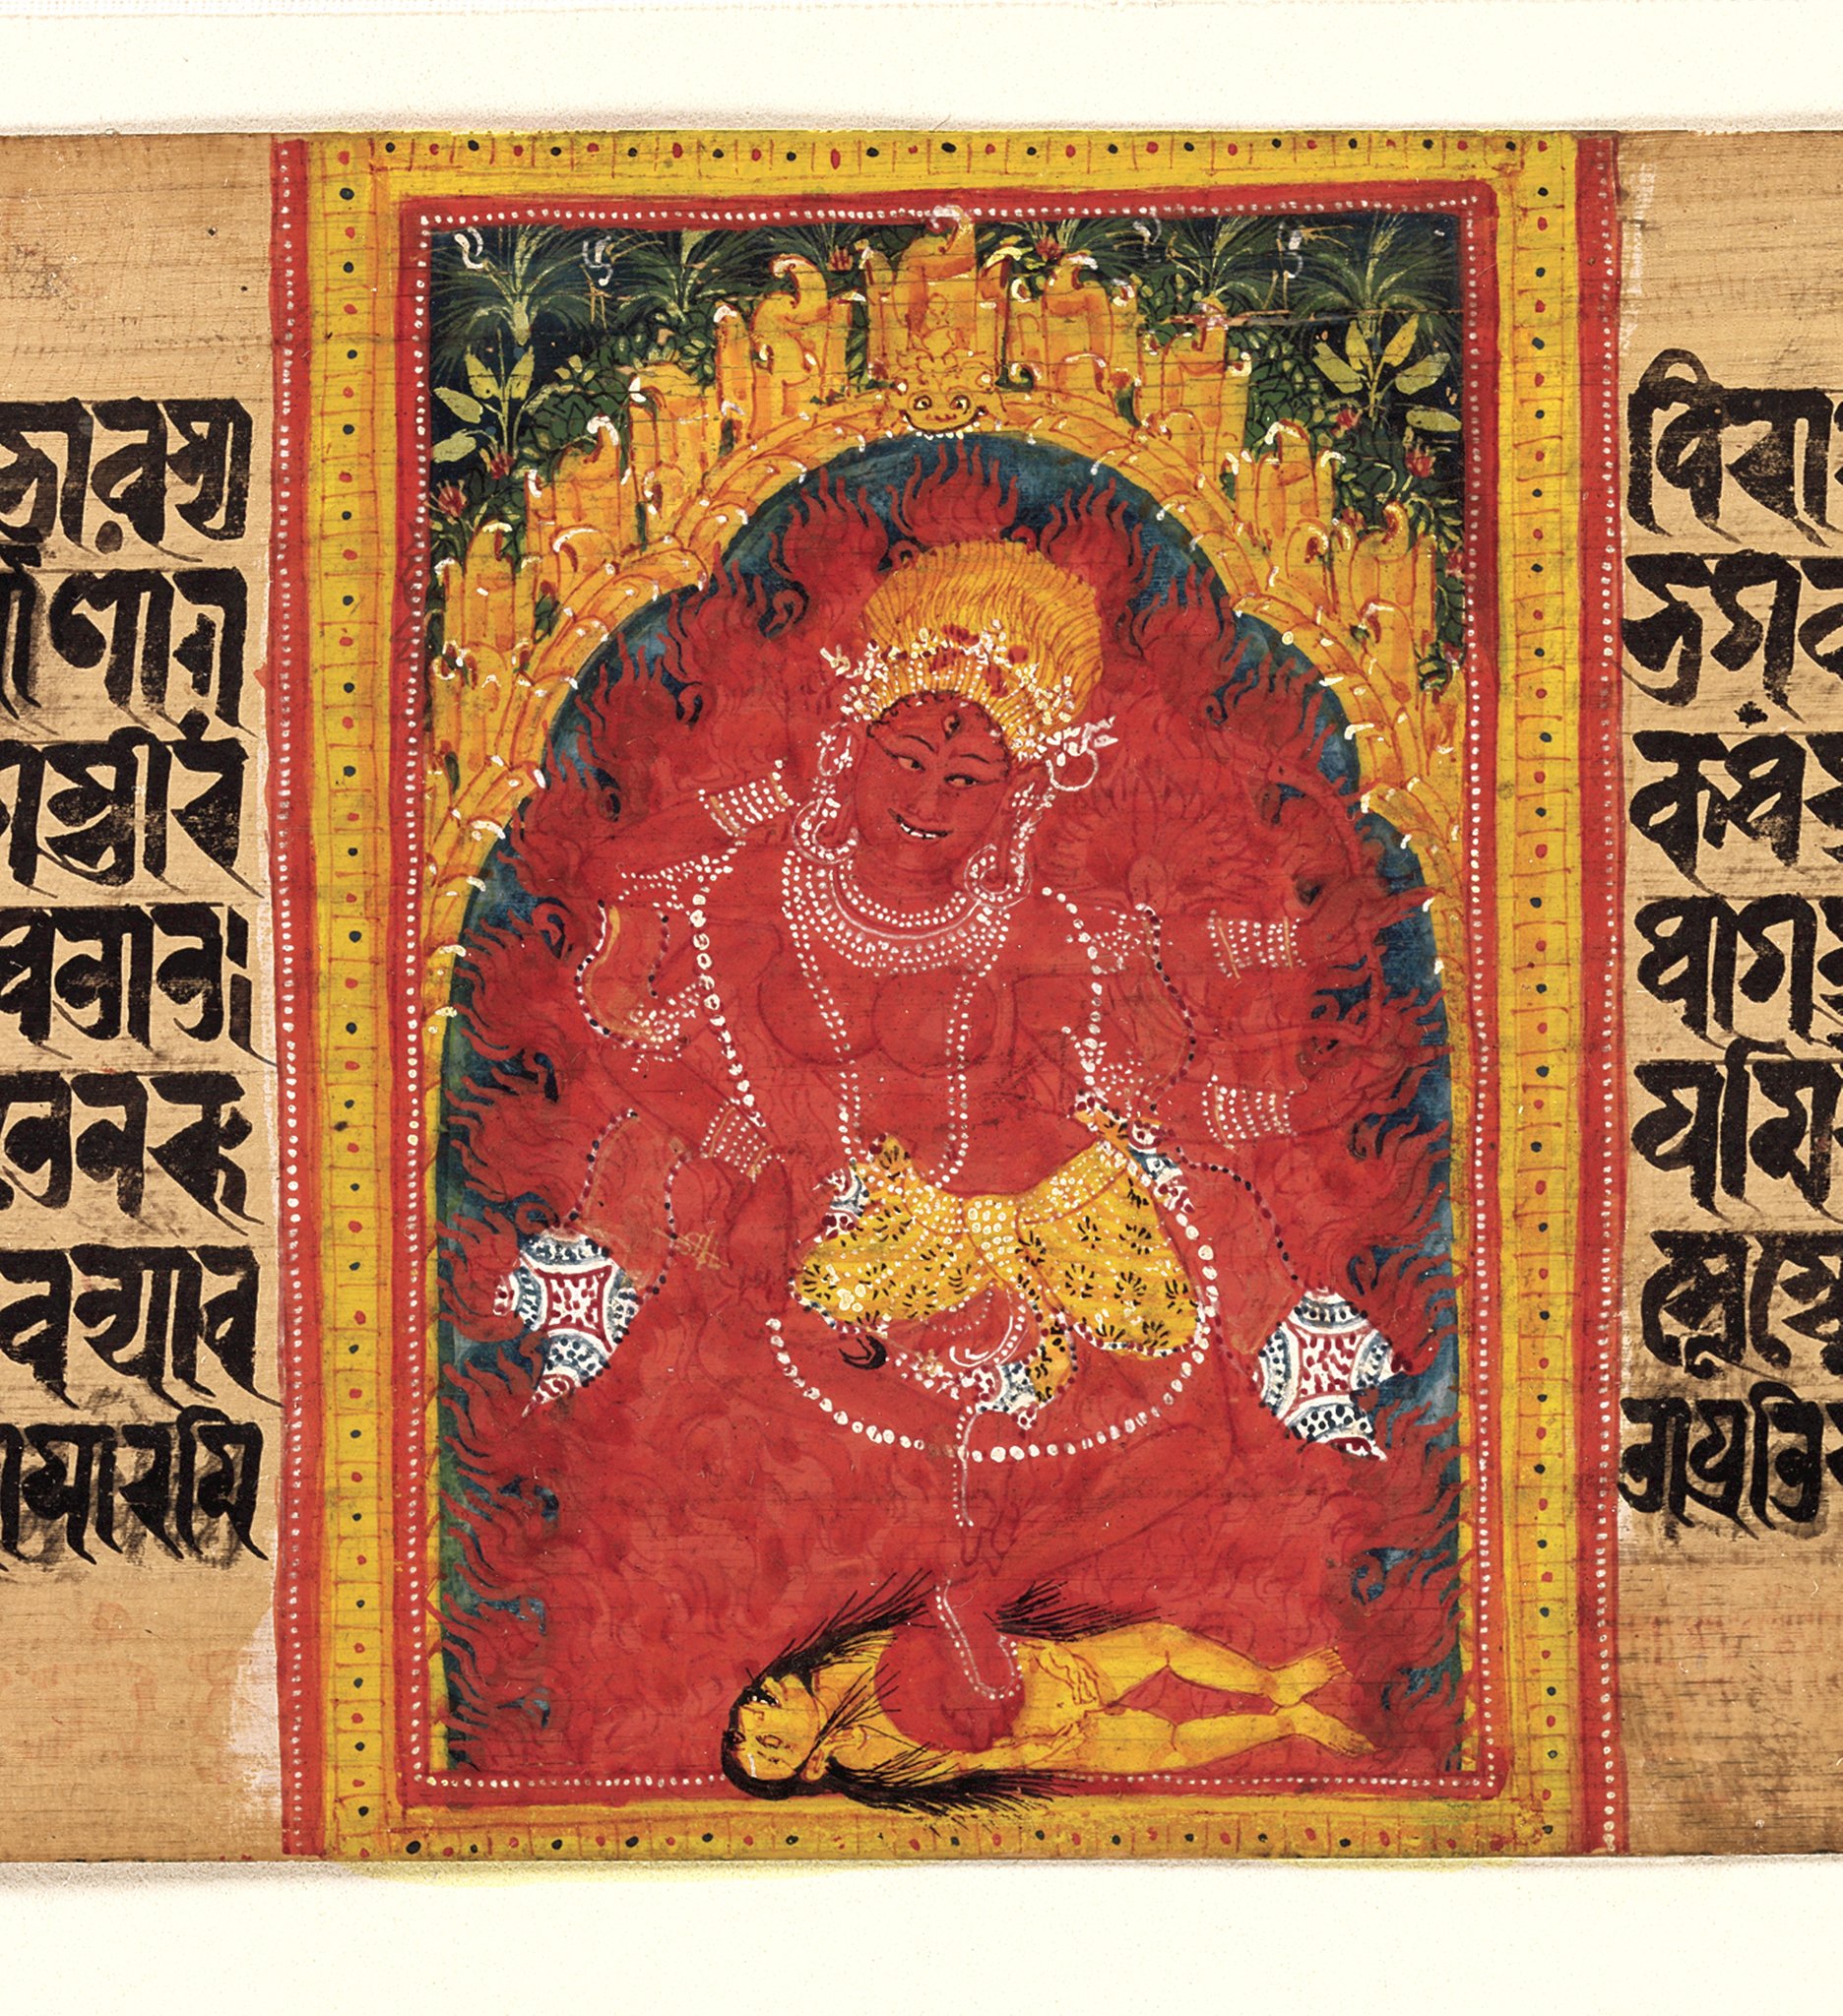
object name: folio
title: Leaves from an Ashtasahasrika Prajnaparamita Sutra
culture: indian or west bengali or bangladeshi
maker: mahavihara master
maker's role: artist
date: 1101-1133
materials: ink, leaf, pigment, watercolor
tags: dancing,buddhism,deities